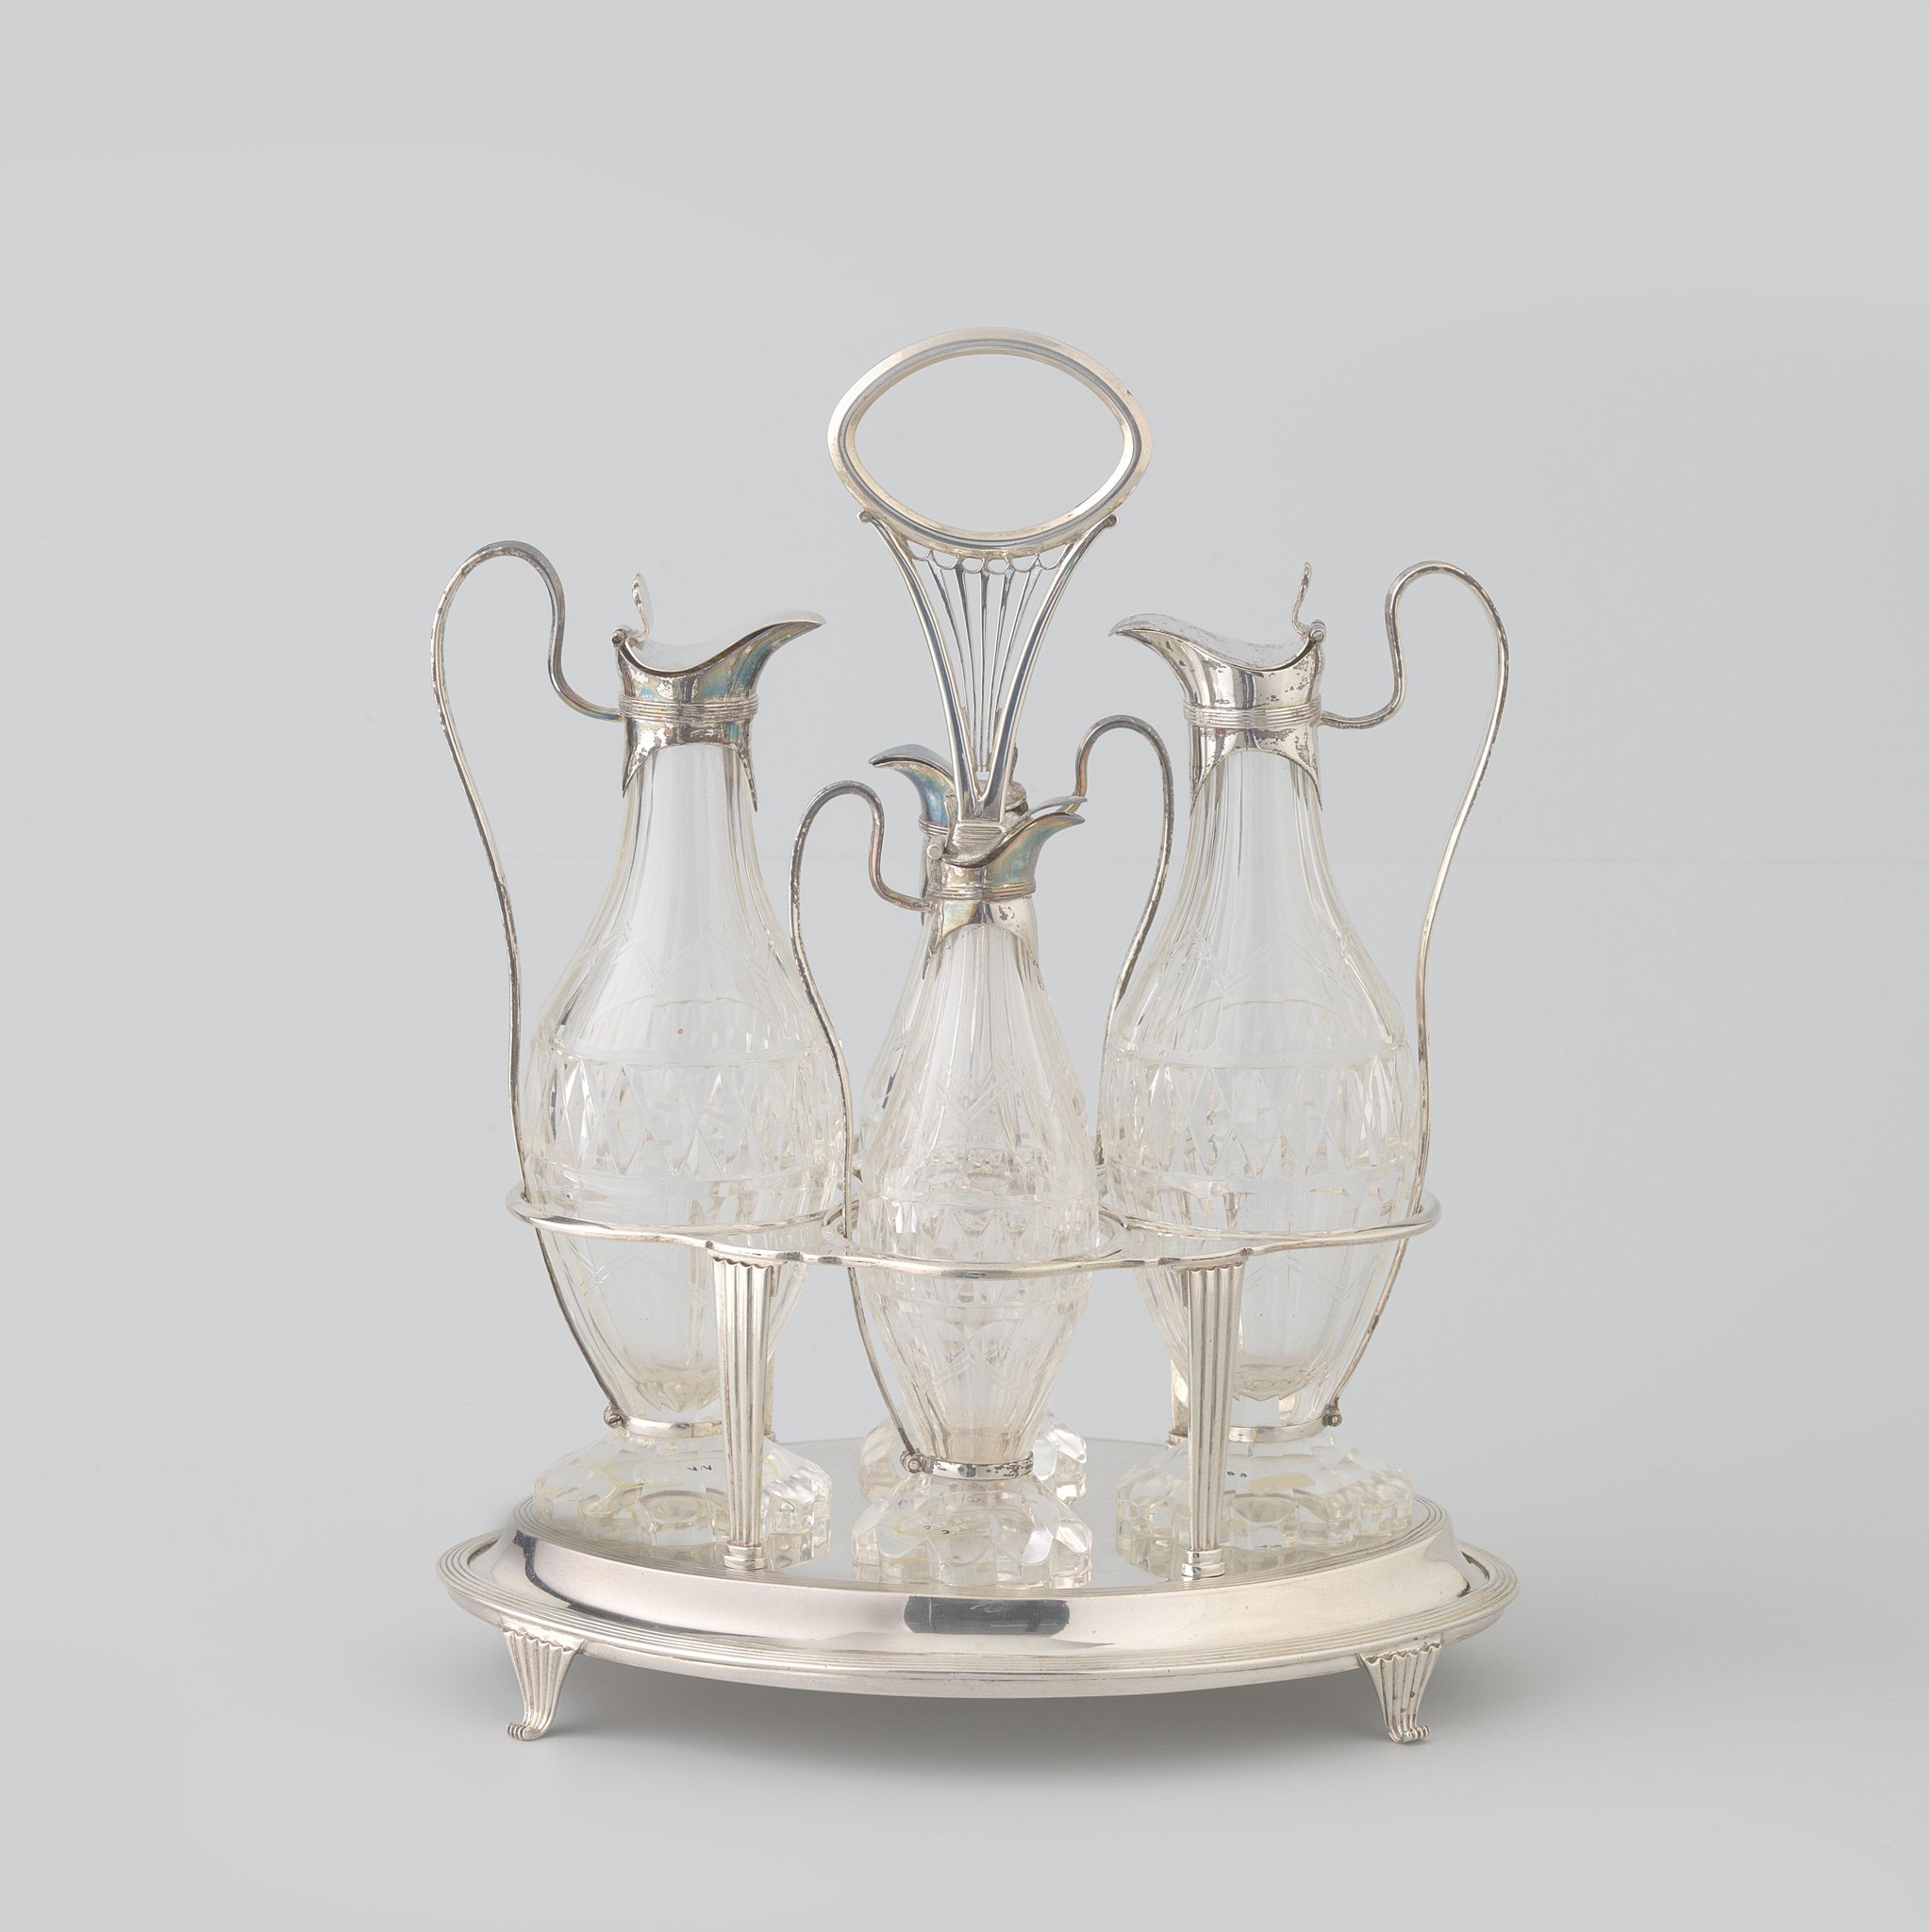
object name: cruet set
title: Fles van olie en azijnstel met vier flessen, met het familiewapen Clifford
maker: hendrik smits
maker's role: silversmith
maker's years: 1772-1841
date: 1806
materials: glass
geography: amsterdam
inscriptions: mark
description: Eén van de twee grotere flessen van kleurloos glas, versierd in divers slijpwerk, passen. Het bovenste gedeelte van de fles is gevat in een zilveren montuur die versierd is met een filetrand, waar-onder het aan de voor- en achterzijde in een punt uitloopt. Op de montuur is een van een greep voorzien, scharnierend snebvormig deksel bevestigd. De, vermoedelijk Engelse, fles heeft een hoog oplopend, gebogen, gegroefd zilveren oor, dat loopt van net boven de flessenvoet tot onder het klapdeksel..